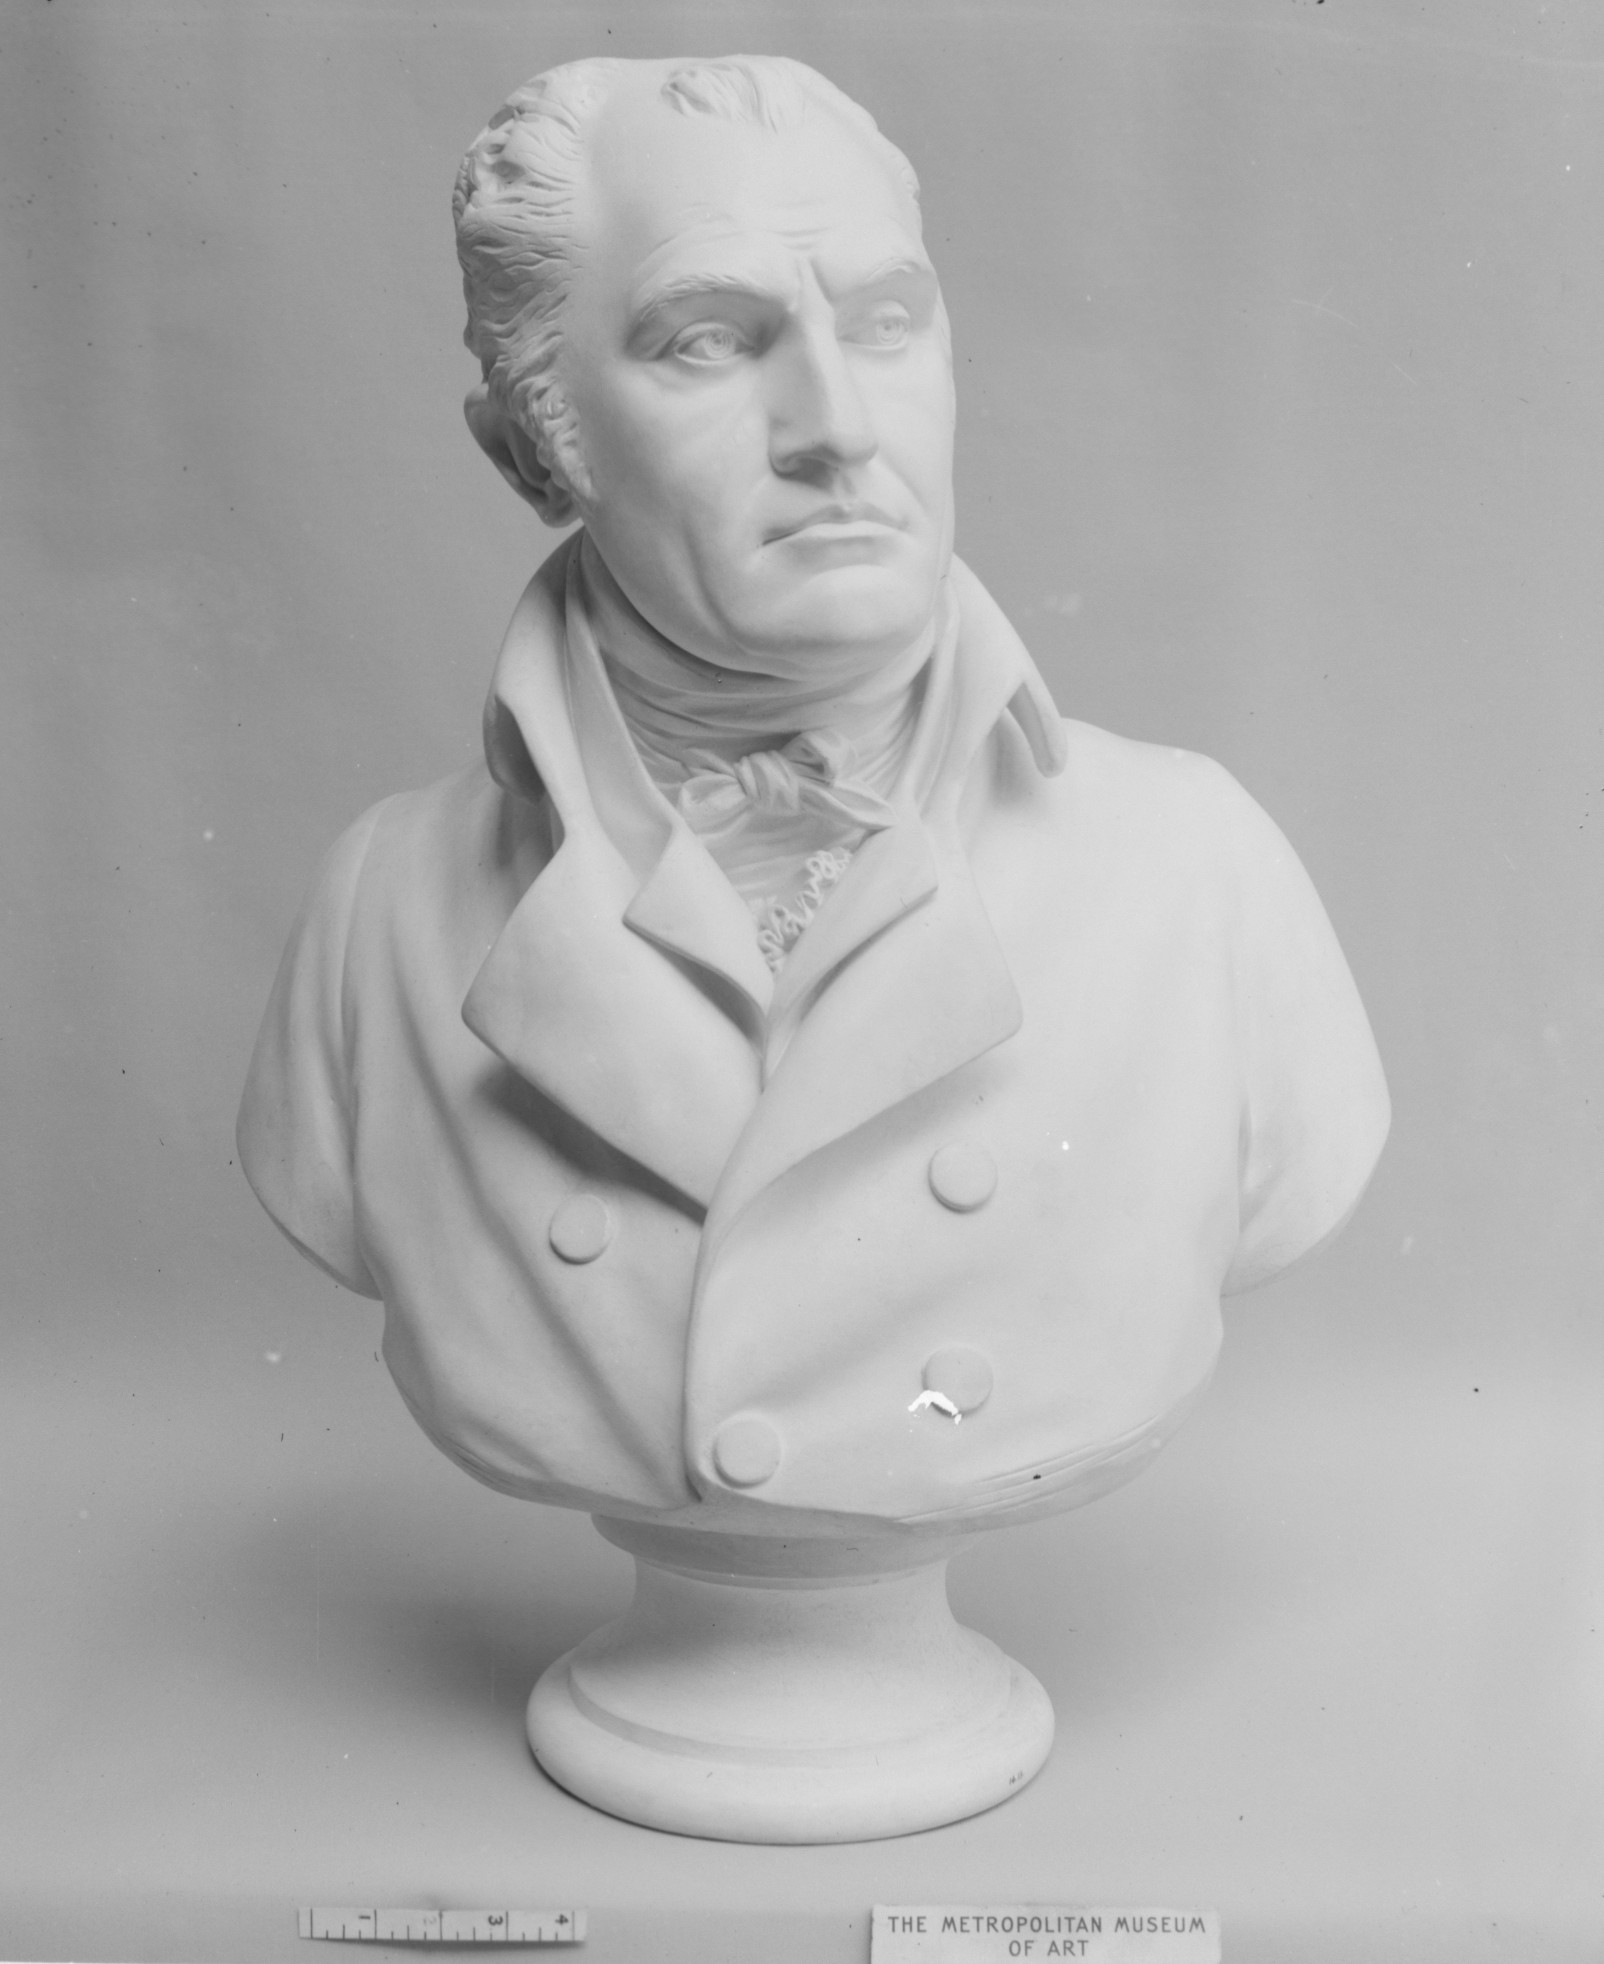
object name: bust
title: Joel Barlow (1754–1812)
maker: jean antoine houdon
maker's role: artist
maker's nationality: french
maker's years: 1741-1828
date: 1701-1800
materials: plaster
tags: men,portraits